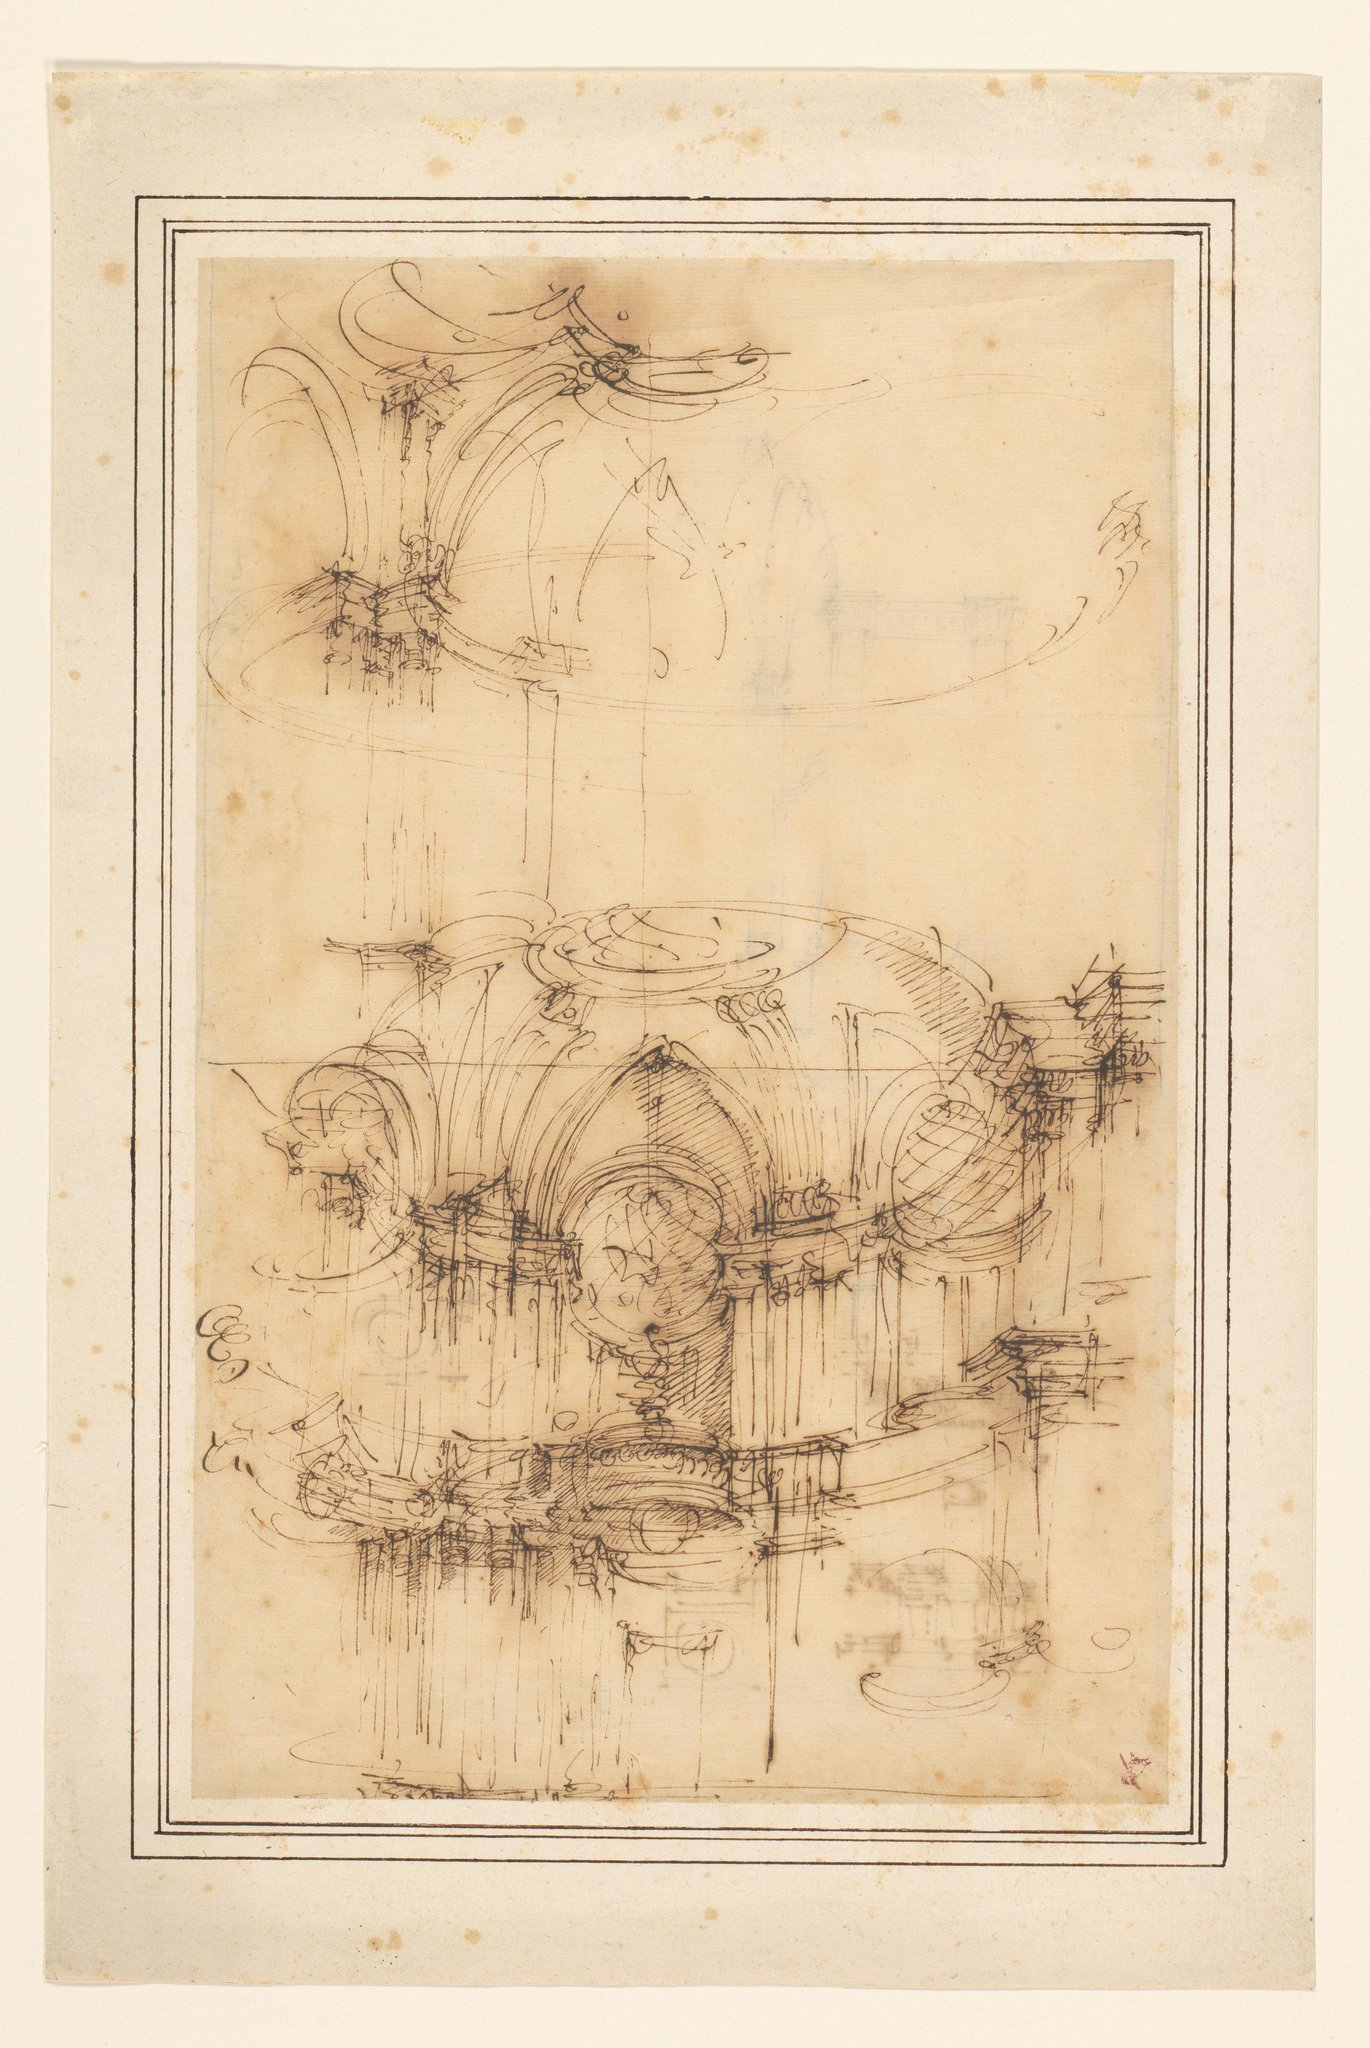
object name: drawing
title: Twee ontwerpschetsen voor de hal van een paleis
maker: giuseppe galli bibiena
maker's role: designer, draughtsman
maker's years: 1696-1756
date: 1710-1773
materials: ink, paper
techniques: pen